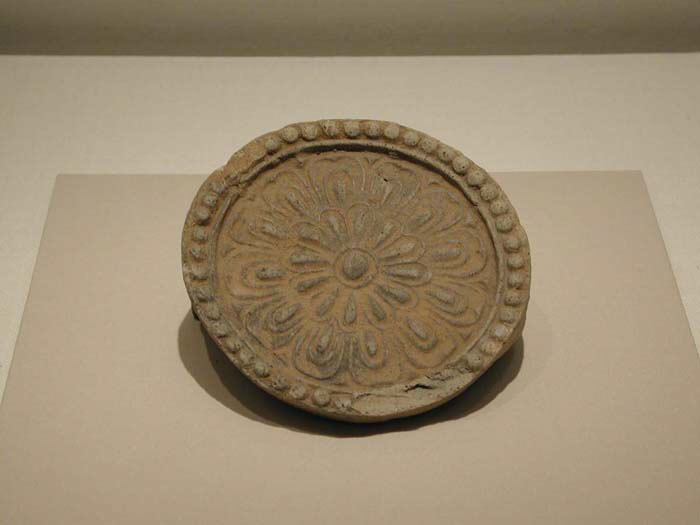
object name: tile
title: Roof End Tile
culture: korean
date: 701-900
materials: stoneware